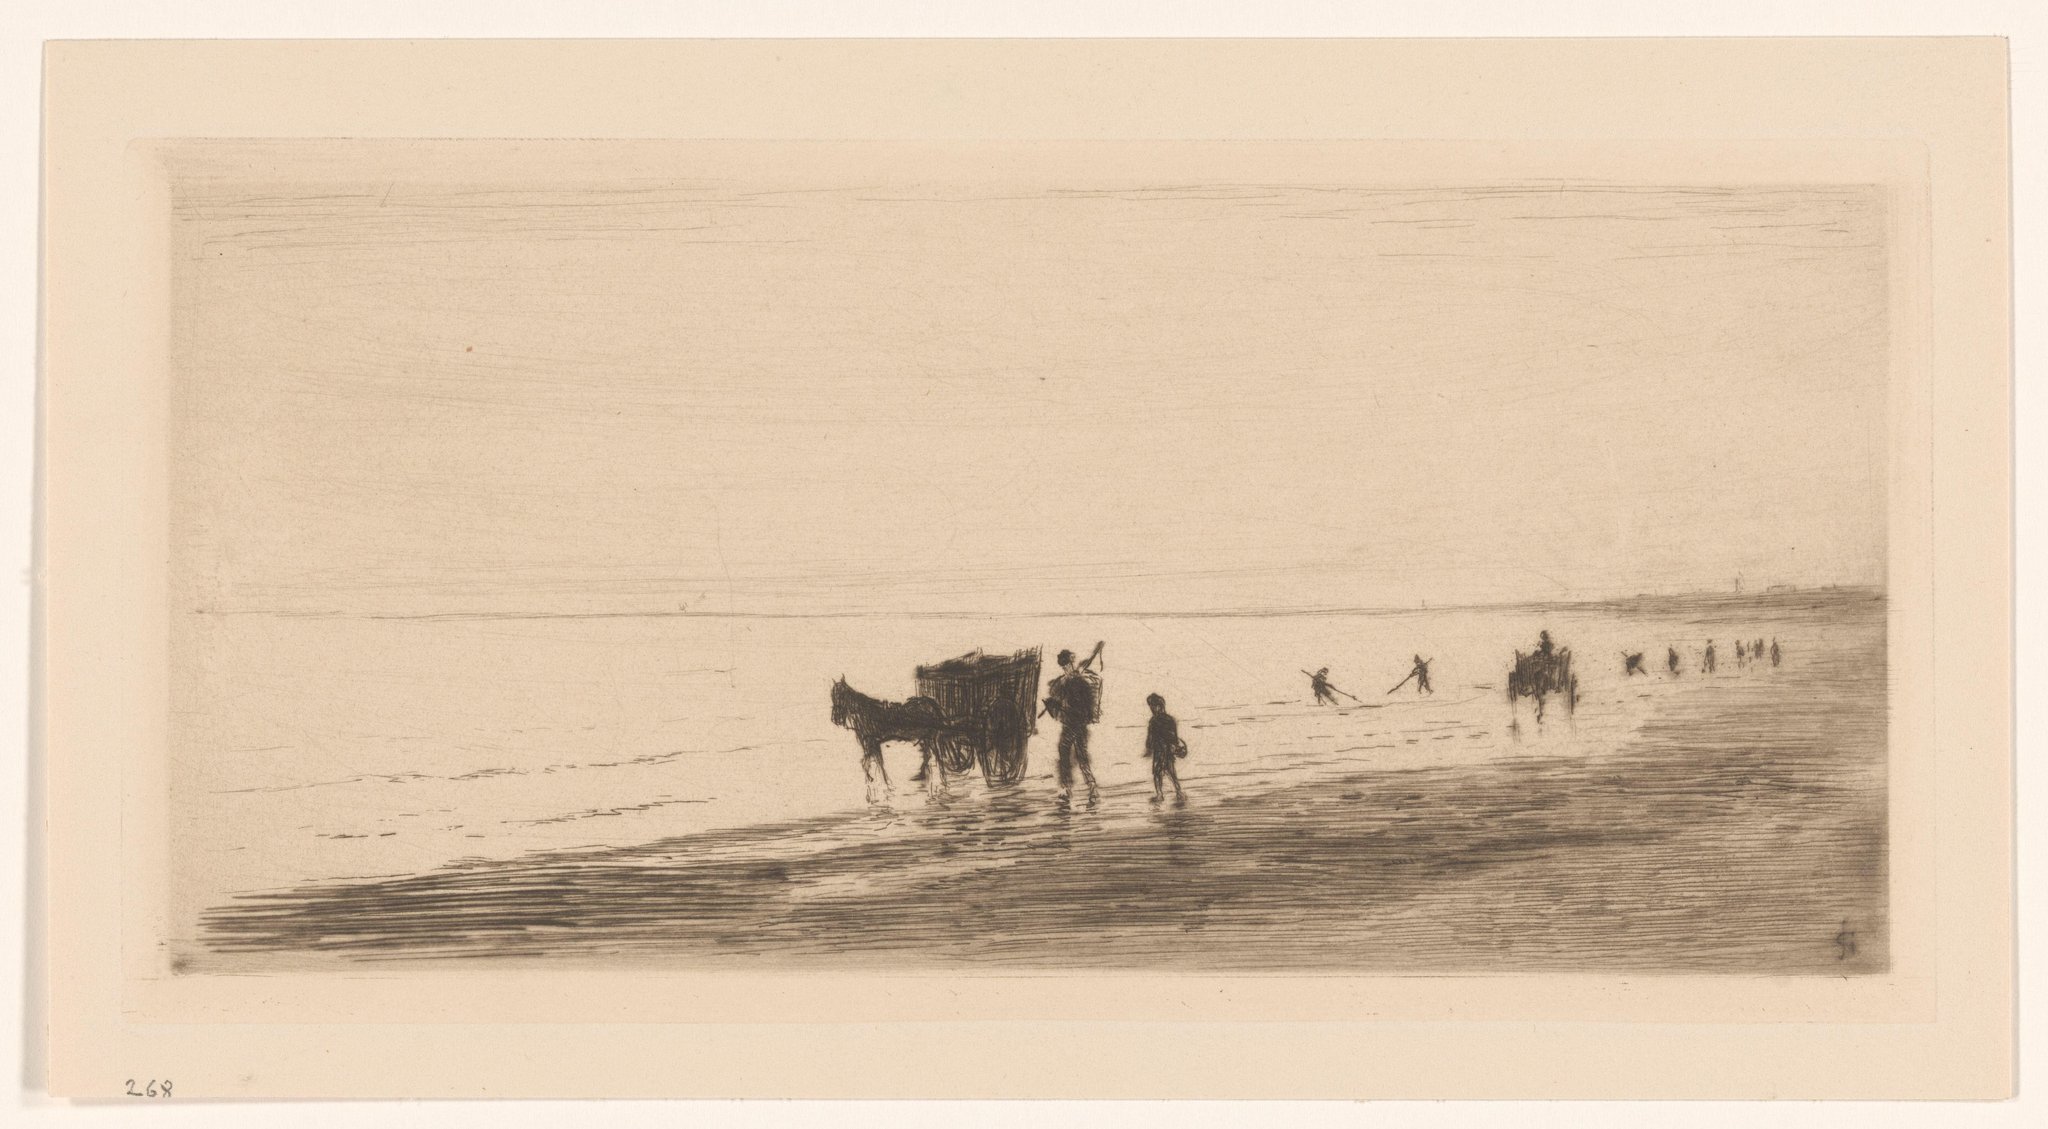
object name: print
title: Schelpenvissers bij Katwijk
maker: carel nicolaas storm van s-gravesande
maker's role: draughtsman, print maker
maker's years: 1841-1924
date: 1887-1889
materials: paper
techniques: drypoint, intaglio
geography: netherlands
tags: crustacean fishery, beach (+ landscape with figures, staffage)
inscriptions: collector's mark: Lugt 2228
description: In de branding lopen schelpenvissers met manden en paard-en-wagens.